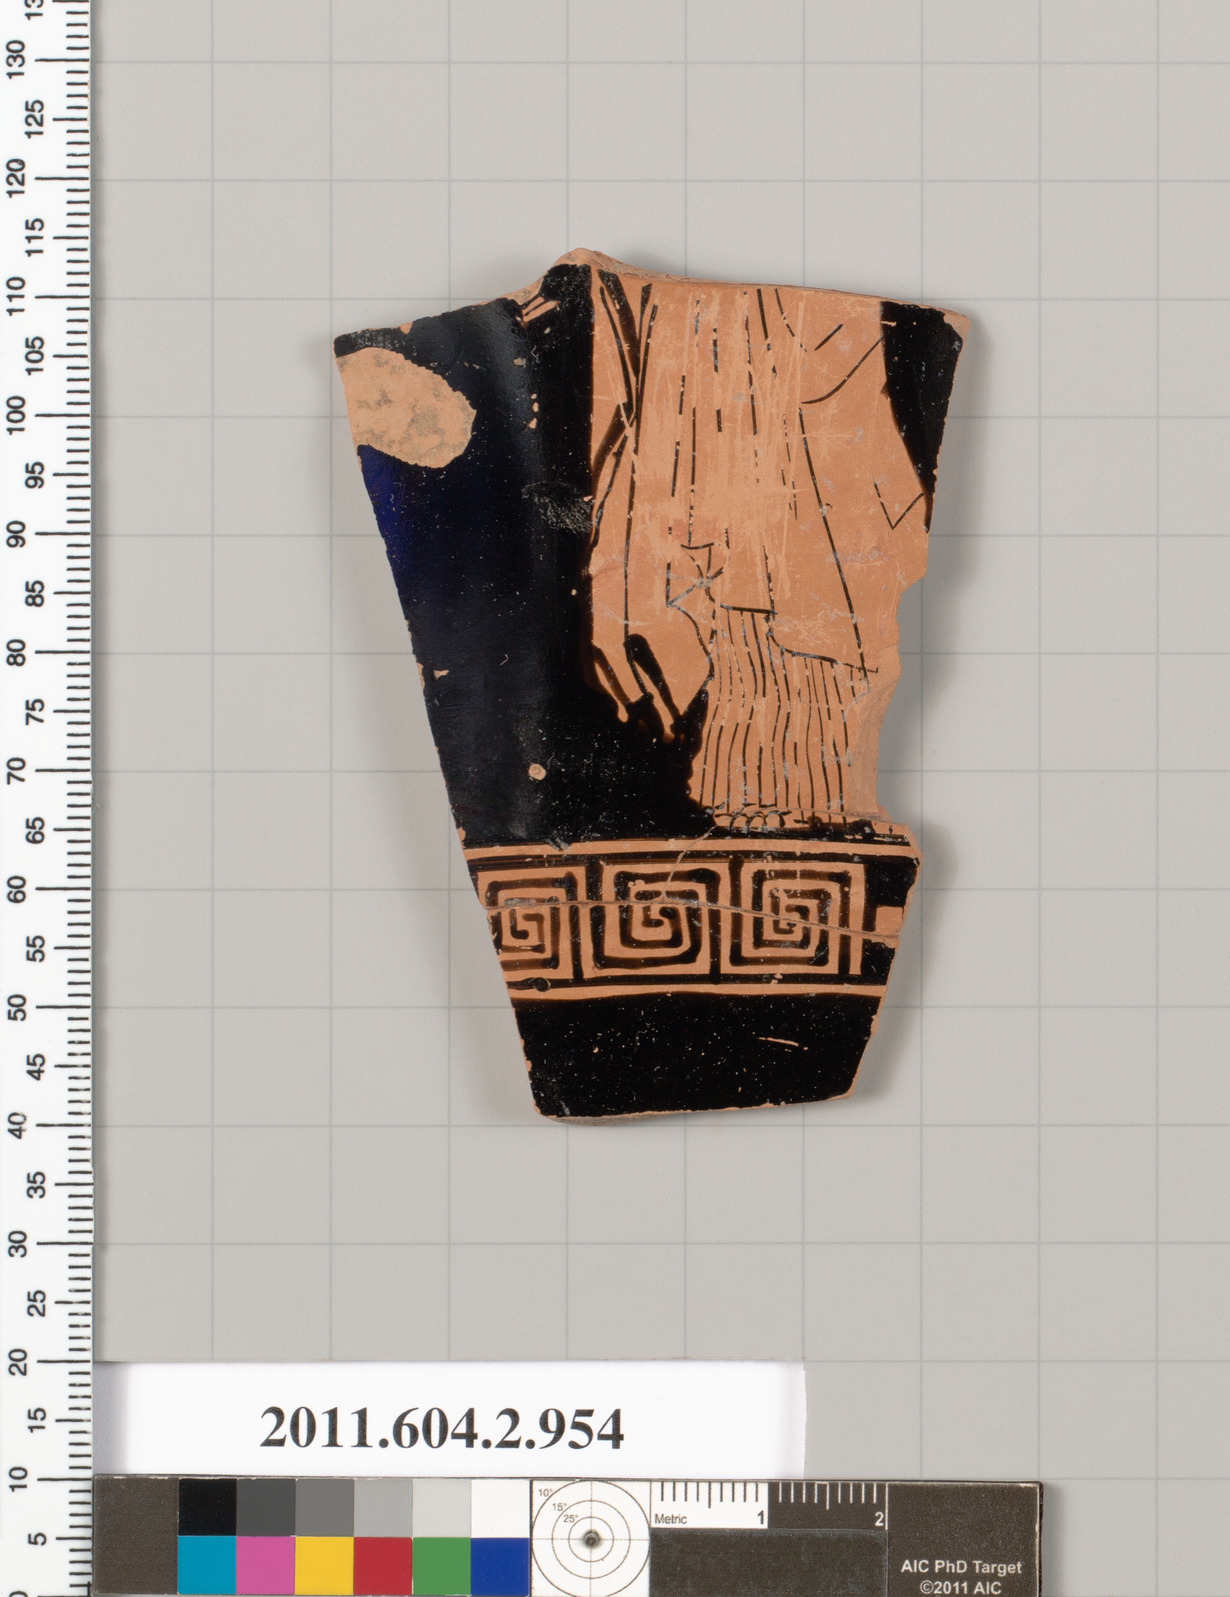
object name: oinochoe fragment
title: Terracotta fragment of an oinochoe (jug)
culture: greek, attic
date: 475-451 BCE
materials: terracotta